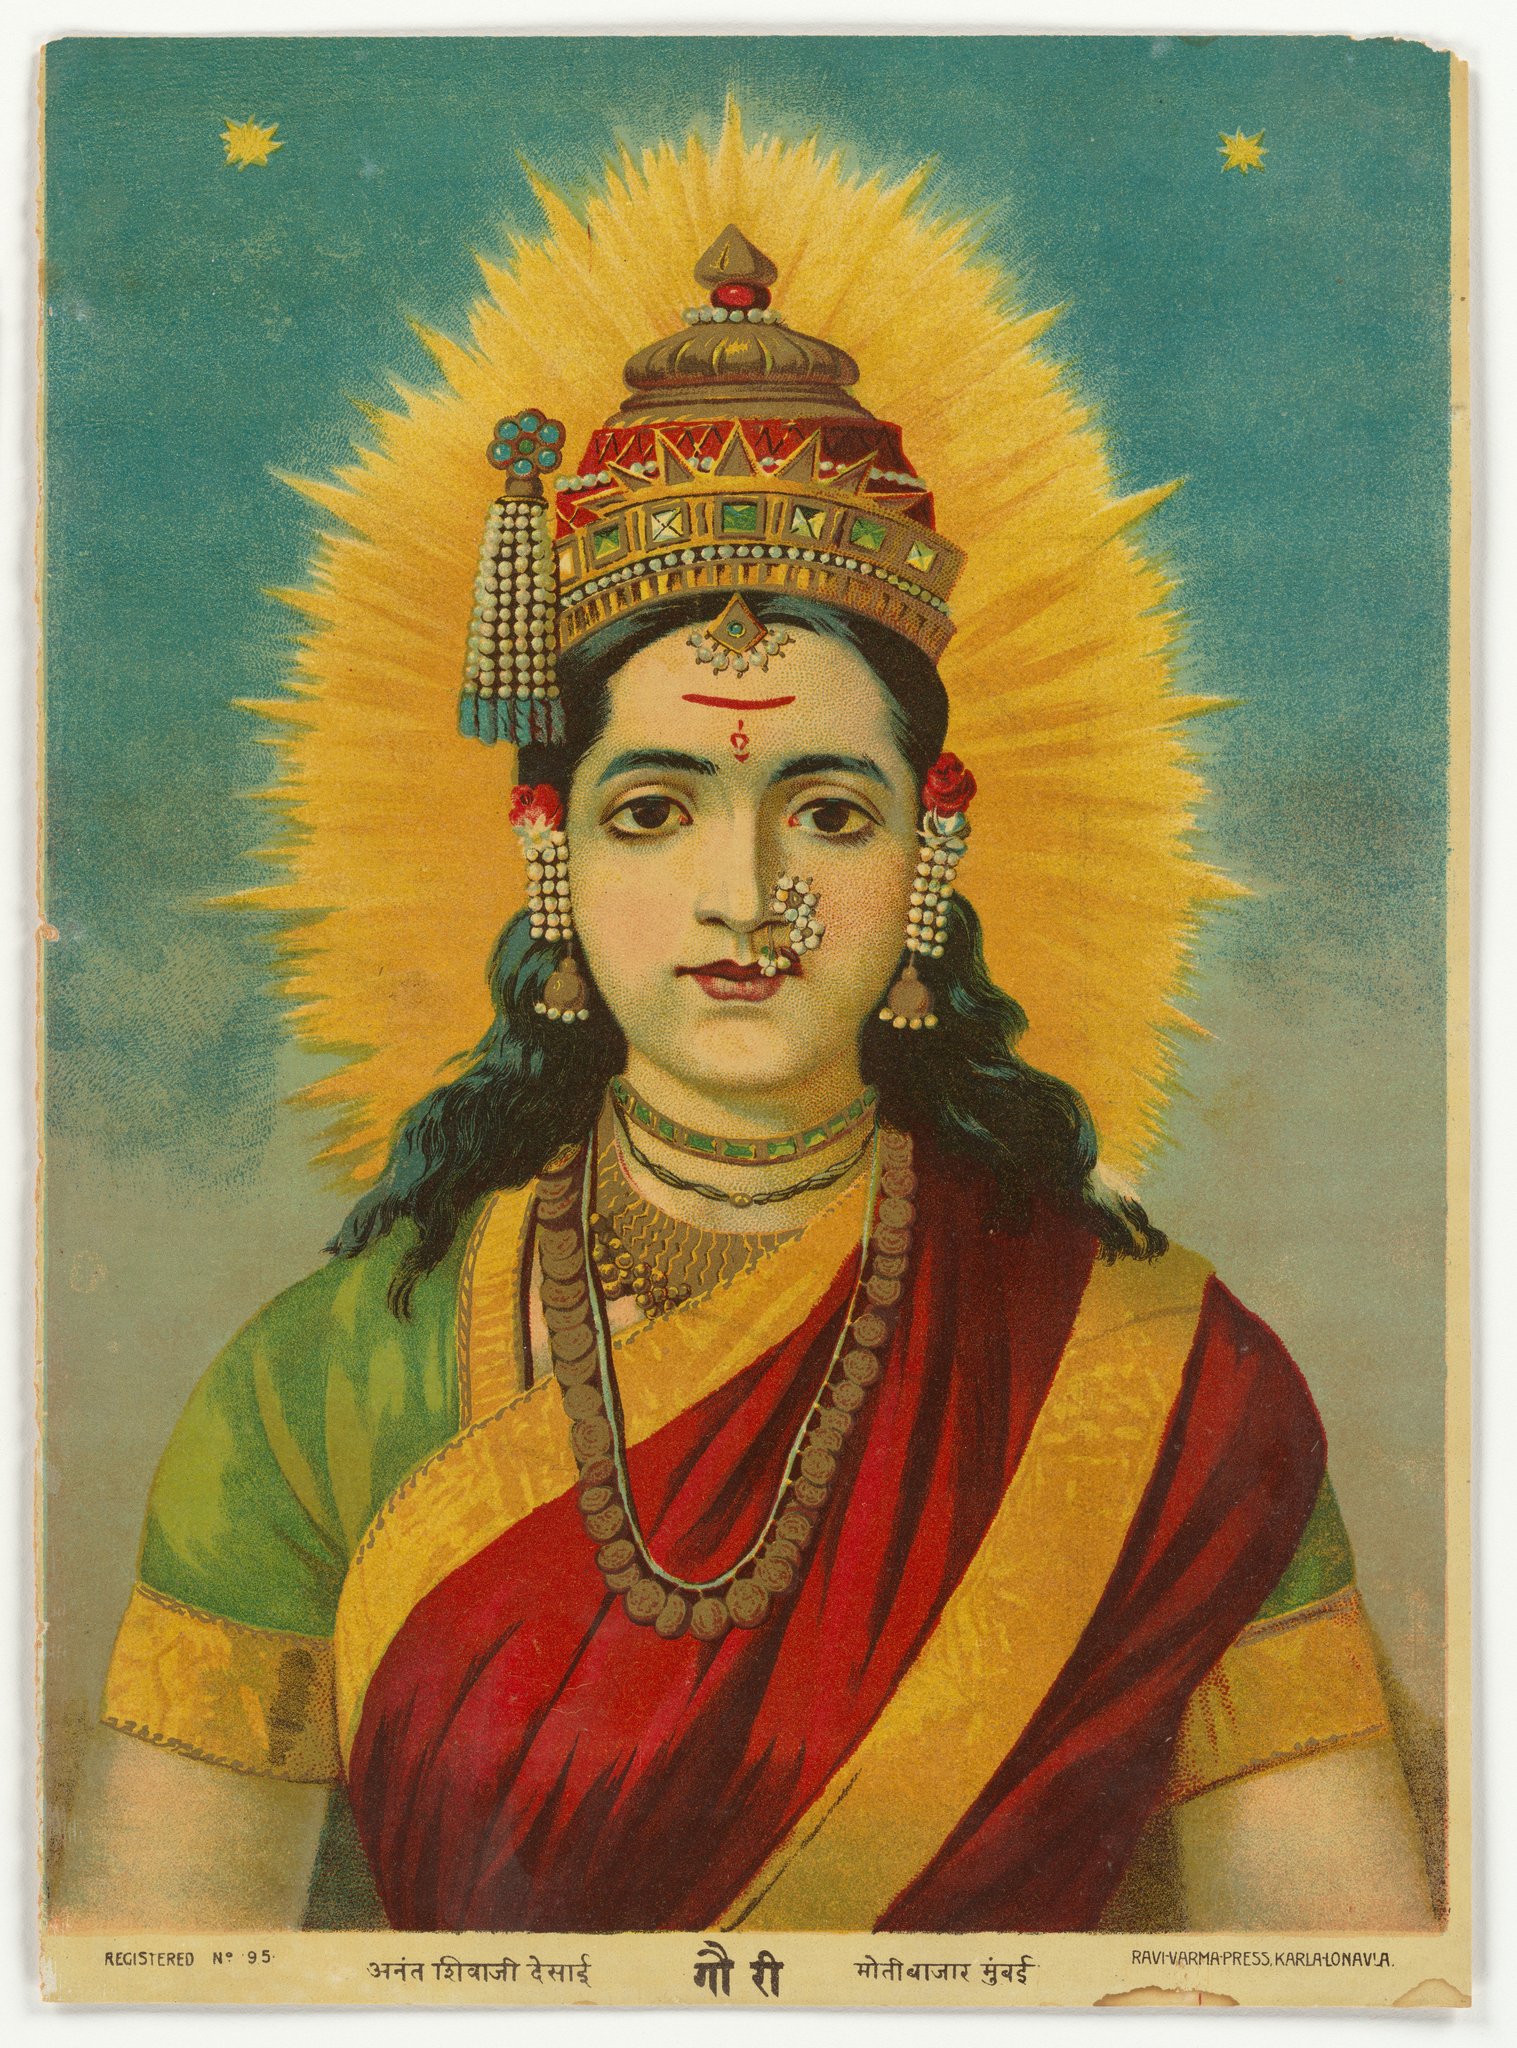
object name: print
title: Gauri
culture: indian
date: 1894-1899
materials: varnish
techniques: lithograph